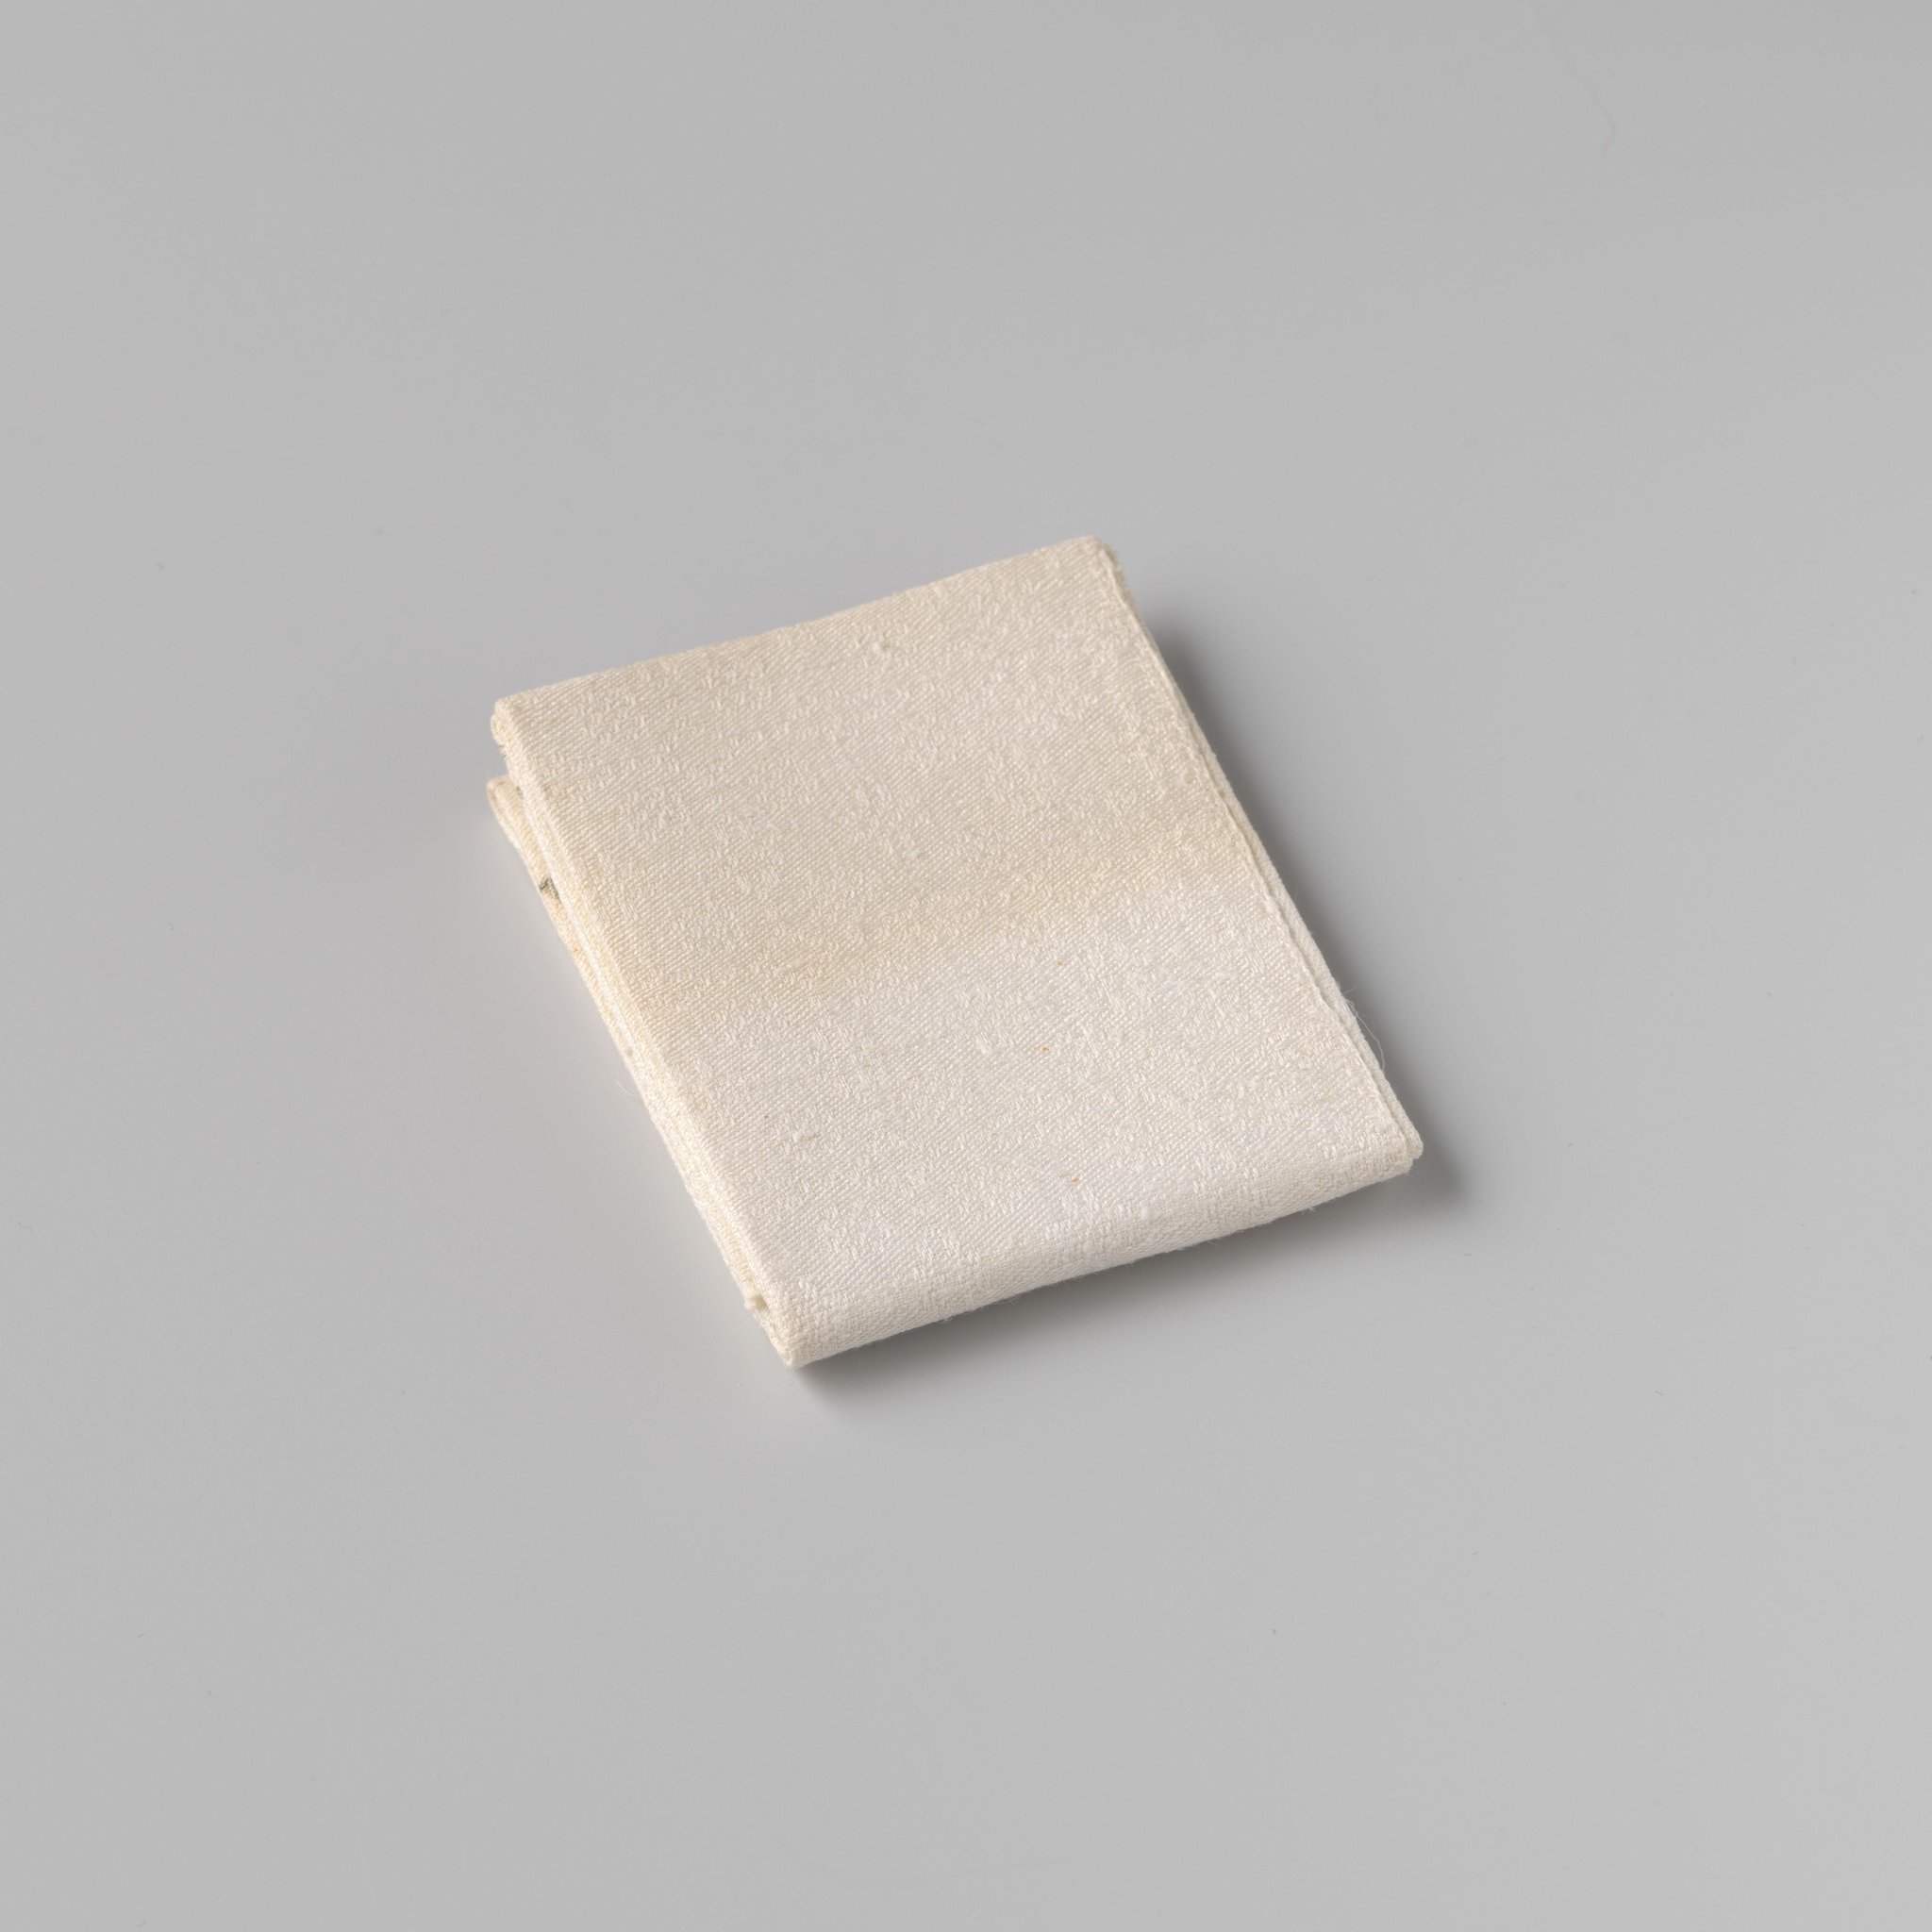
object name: miniature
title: Tafellaken met pellenpatroon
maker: Anonymous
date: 1690-1710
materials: linen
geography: amsterdam